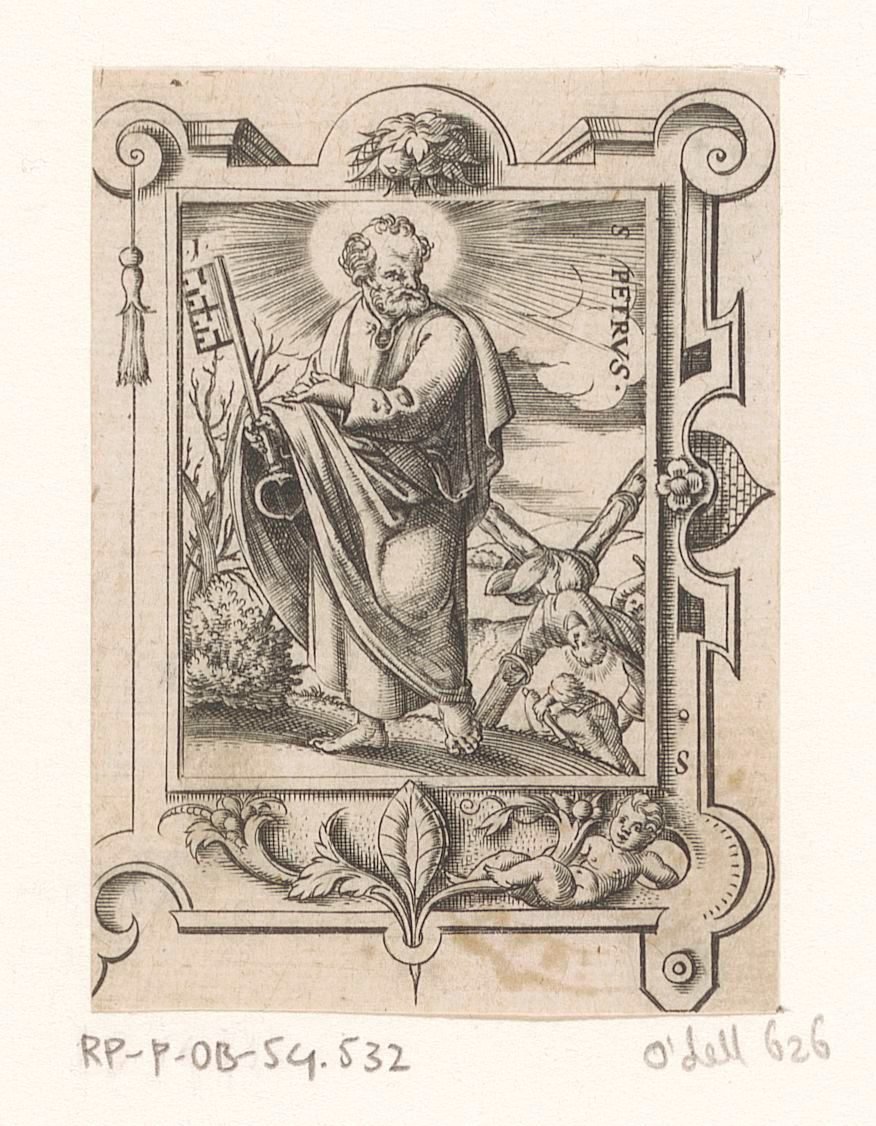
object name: print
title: Heilige Petrus in rolwerk omlijsting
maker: virgilius solis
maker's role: draughtsman, print maker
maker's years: 1514-1562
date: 1568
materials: paper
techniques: engraving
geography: nuremberg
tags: scrollwork, strapwork ~ ornament, peter crucified upside down, the apostle peter, first bishop of rome; possible attributes: book, cock, (upturned) cross, (triple) crozier, fish, key, scroll, ship, tiara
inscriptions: number: ‘87’, collector's mark: Lugt 2228, collector's mark: Lugt 240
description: Prent gebruikt voor het gebedenboek: Solis, Virgil. Ein New Künstlich Betbüchlein. Neurenberg: Hieronymus Petri, 1568. Bij elke prent met afbeelding van een apostel behoort een prent met een gebed in het Latijn en in het Duits. Bij elkaar horende prenten hebben dezelfde nummering en het monogram VS is steeds verspreid over twee bladen met dezelfde nummering.